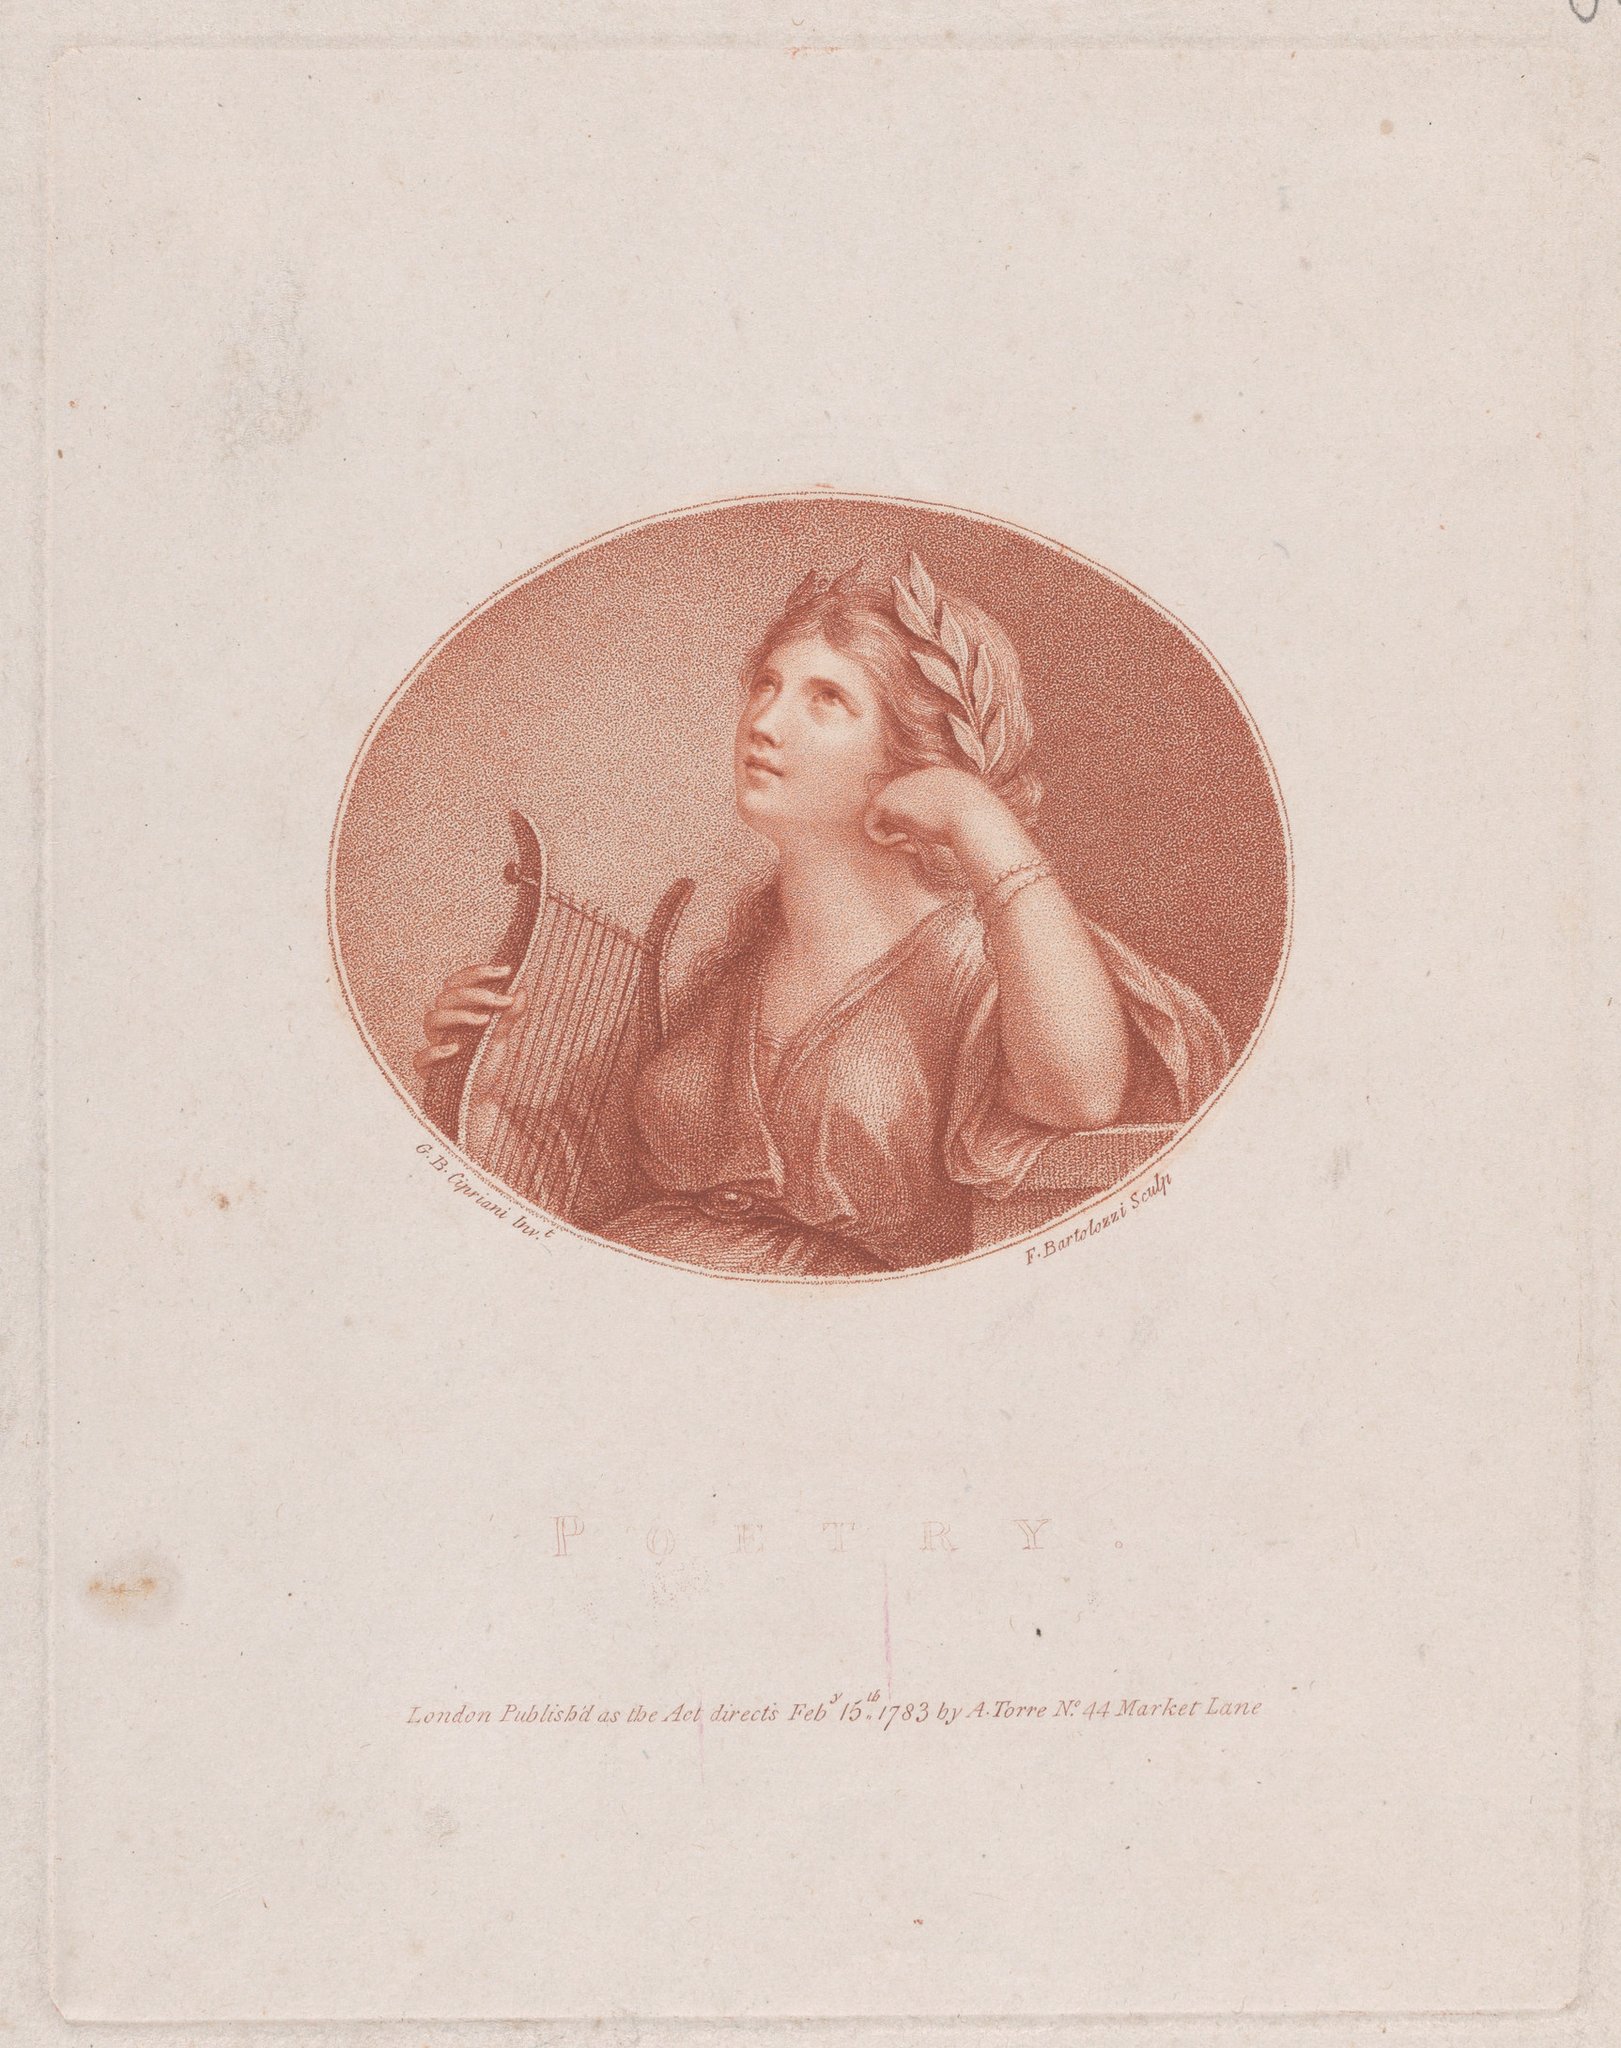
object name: print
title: Poetry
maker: francesco bartolozzi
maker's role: artist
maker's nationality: italian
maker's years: 1728-1815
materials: ink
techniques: etching, printing, engraving